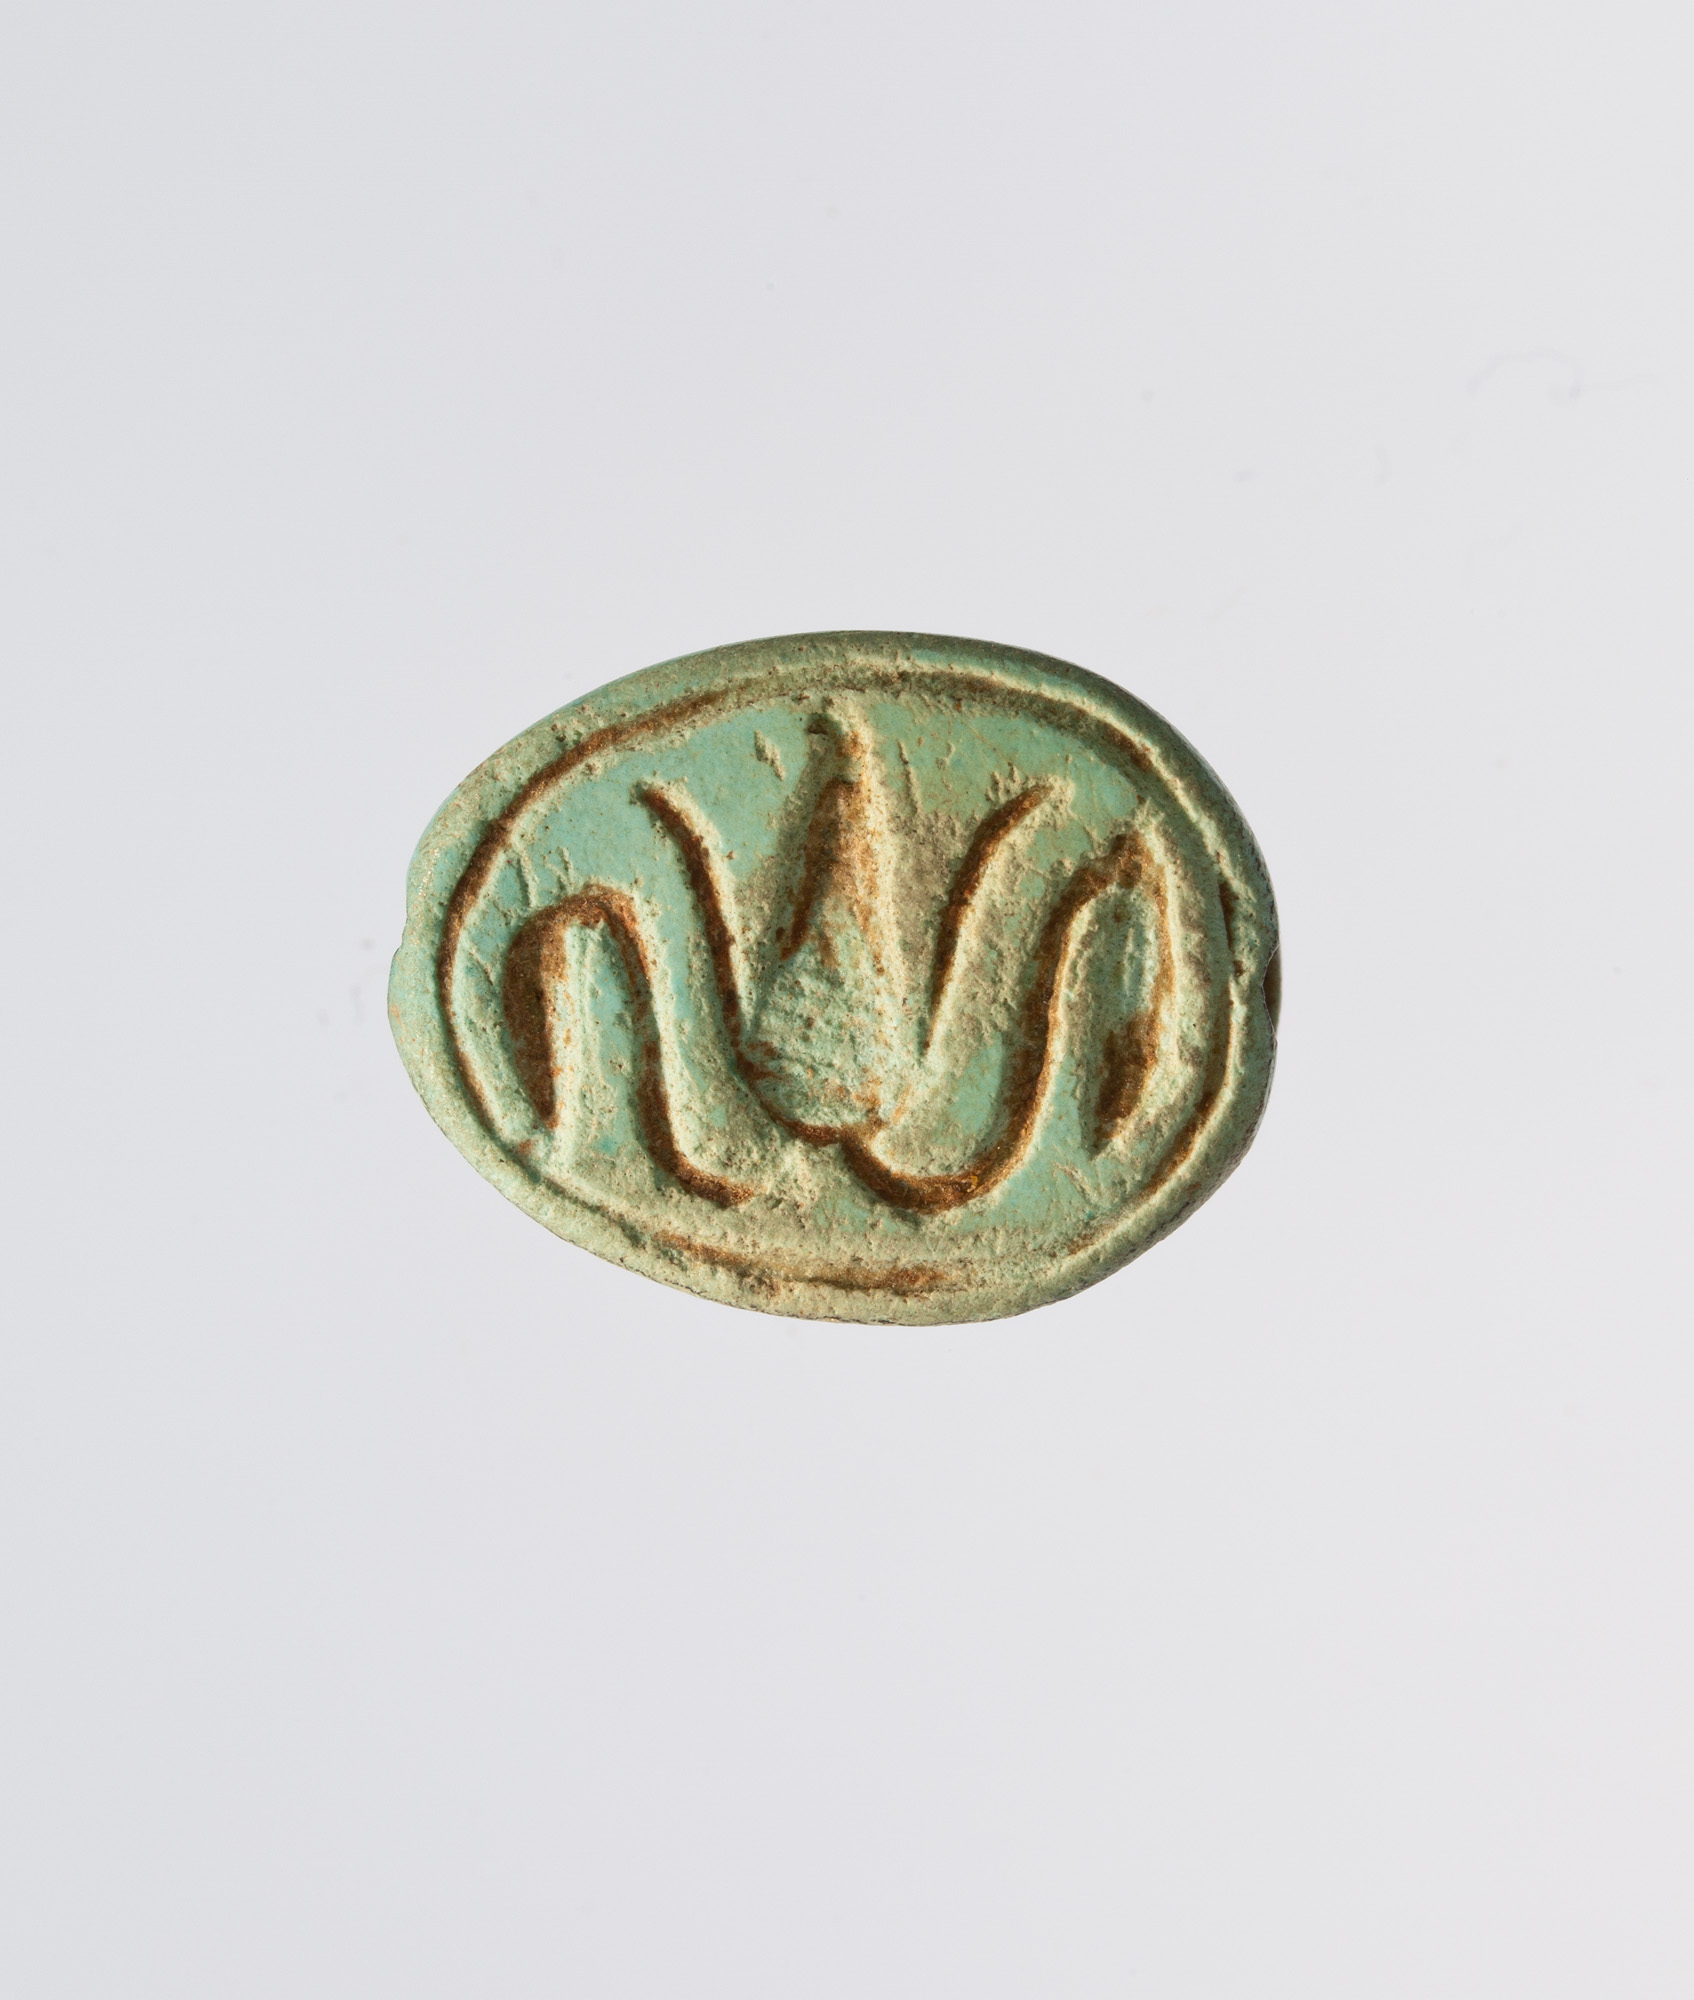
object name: scarab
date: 1479-1458 BCE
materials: faience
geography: egypt